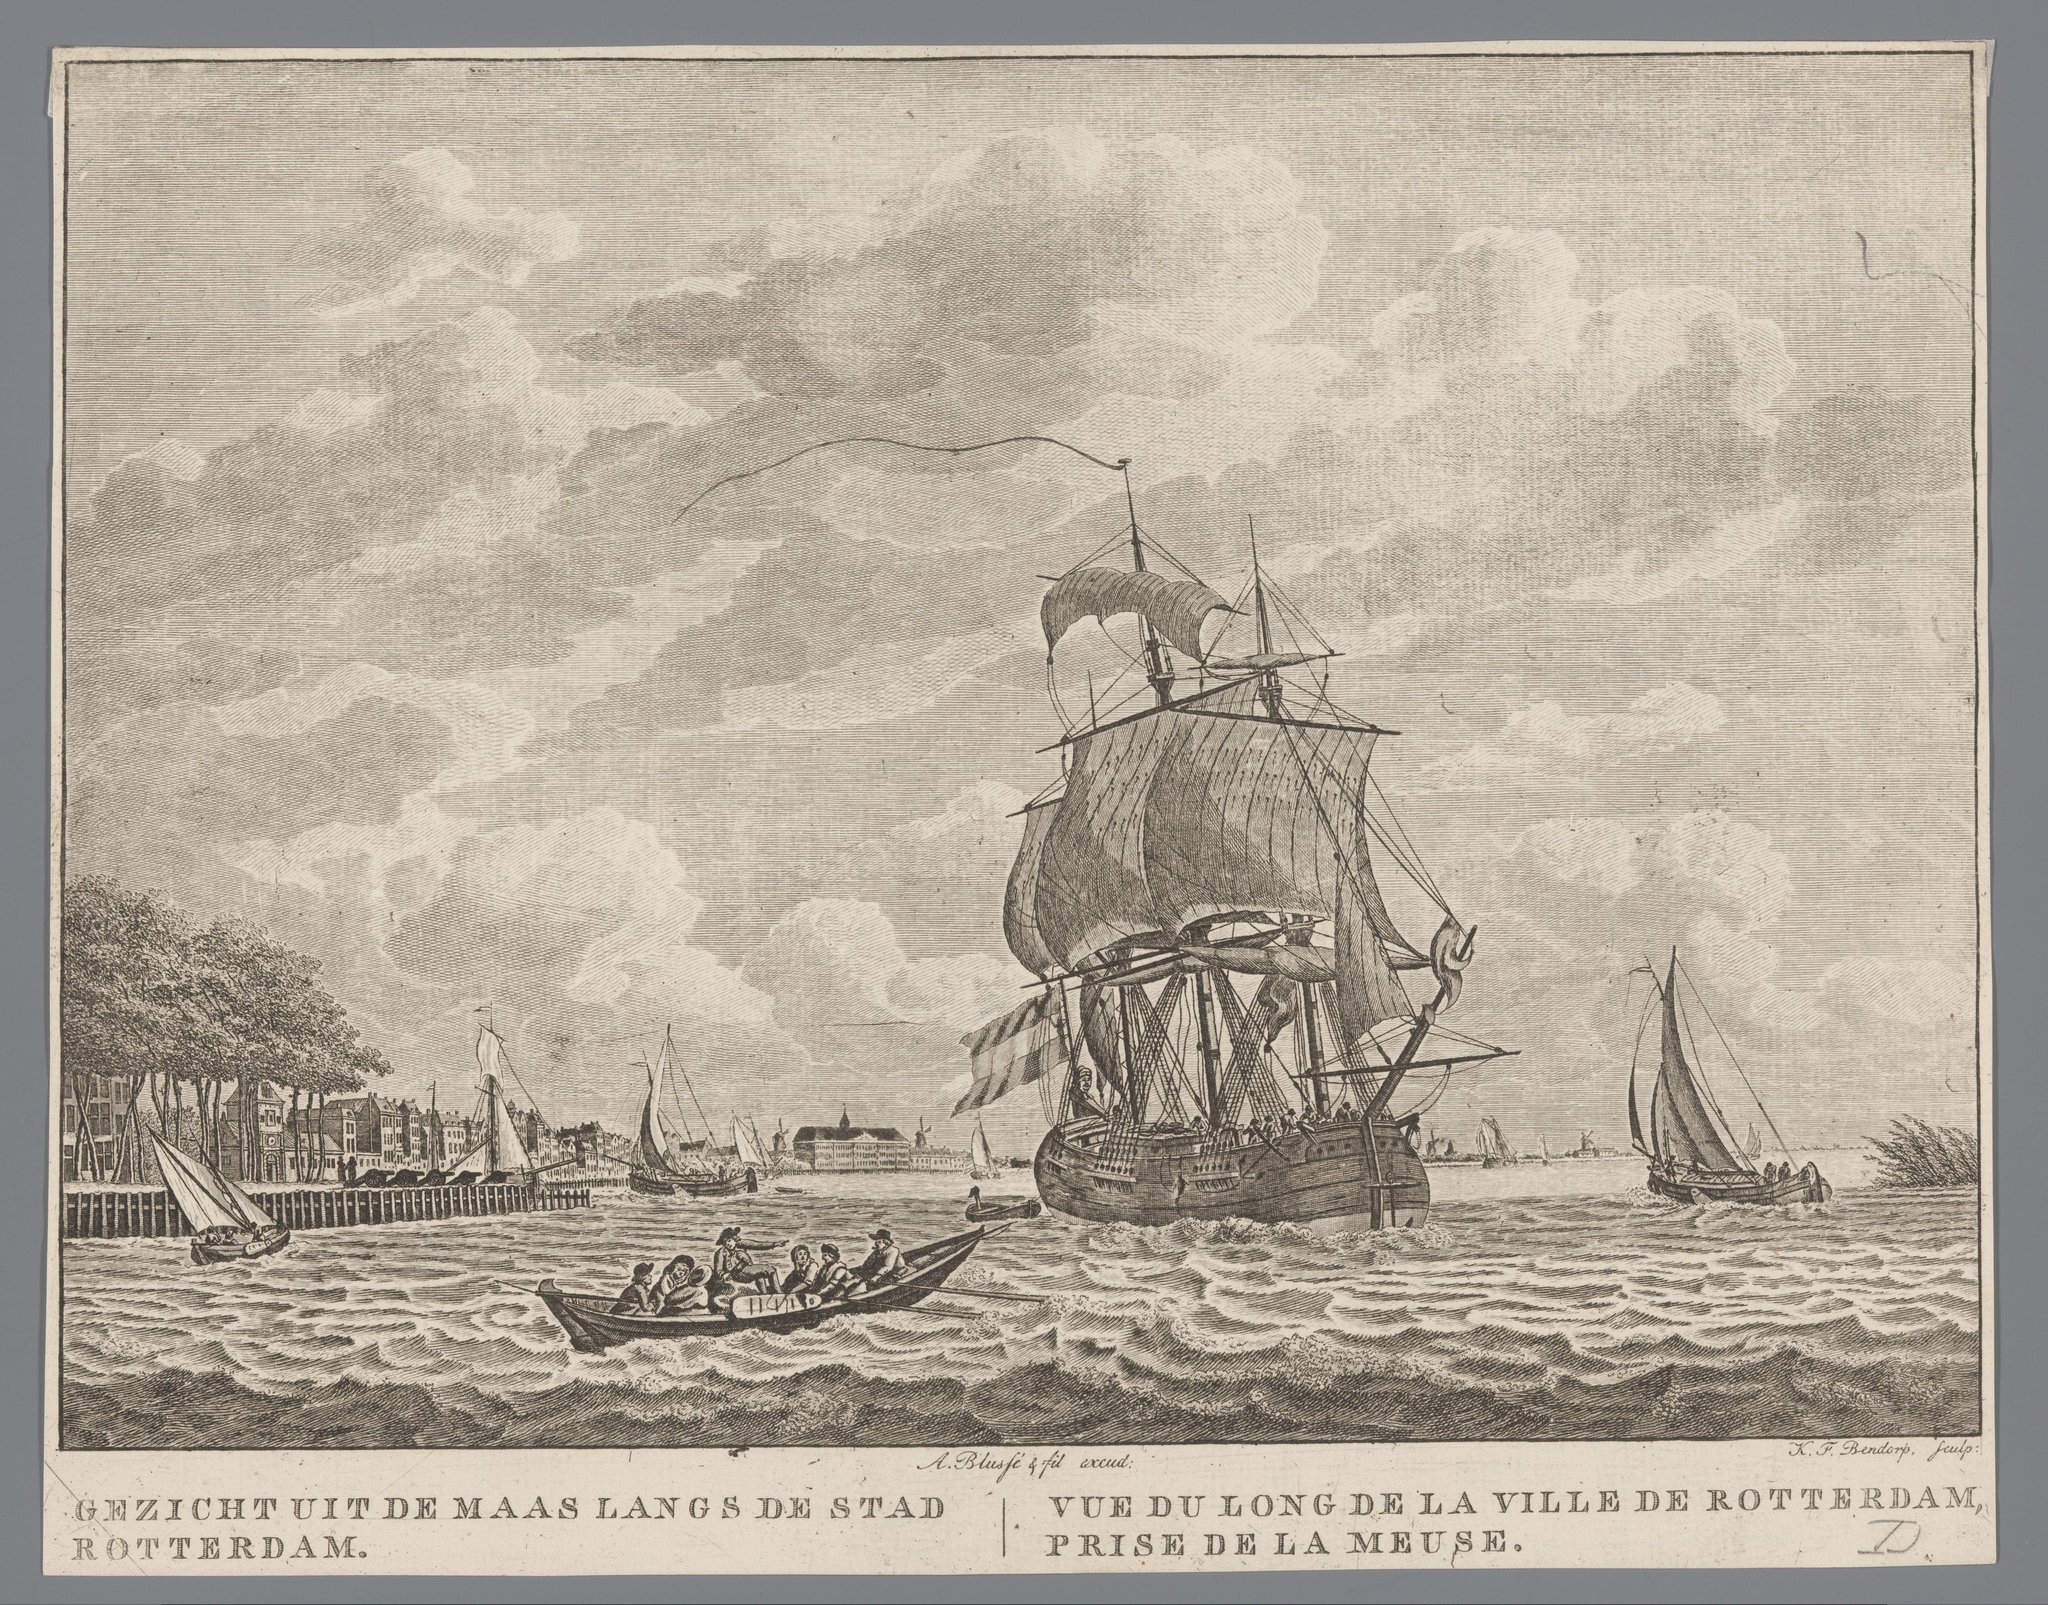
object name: print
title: Gezicht op Rotterdam vanaf de Maas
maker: carel frederik bendorp (i)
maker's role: print maker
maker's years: 1736-1814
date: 1746-1814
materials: paper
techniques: engraving, etching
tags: sailing-ship, sailing-boat, rowing-boat, canoe, etc., canals, waters (in city), rotterdam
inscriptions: collector's mark: Lugt 2228